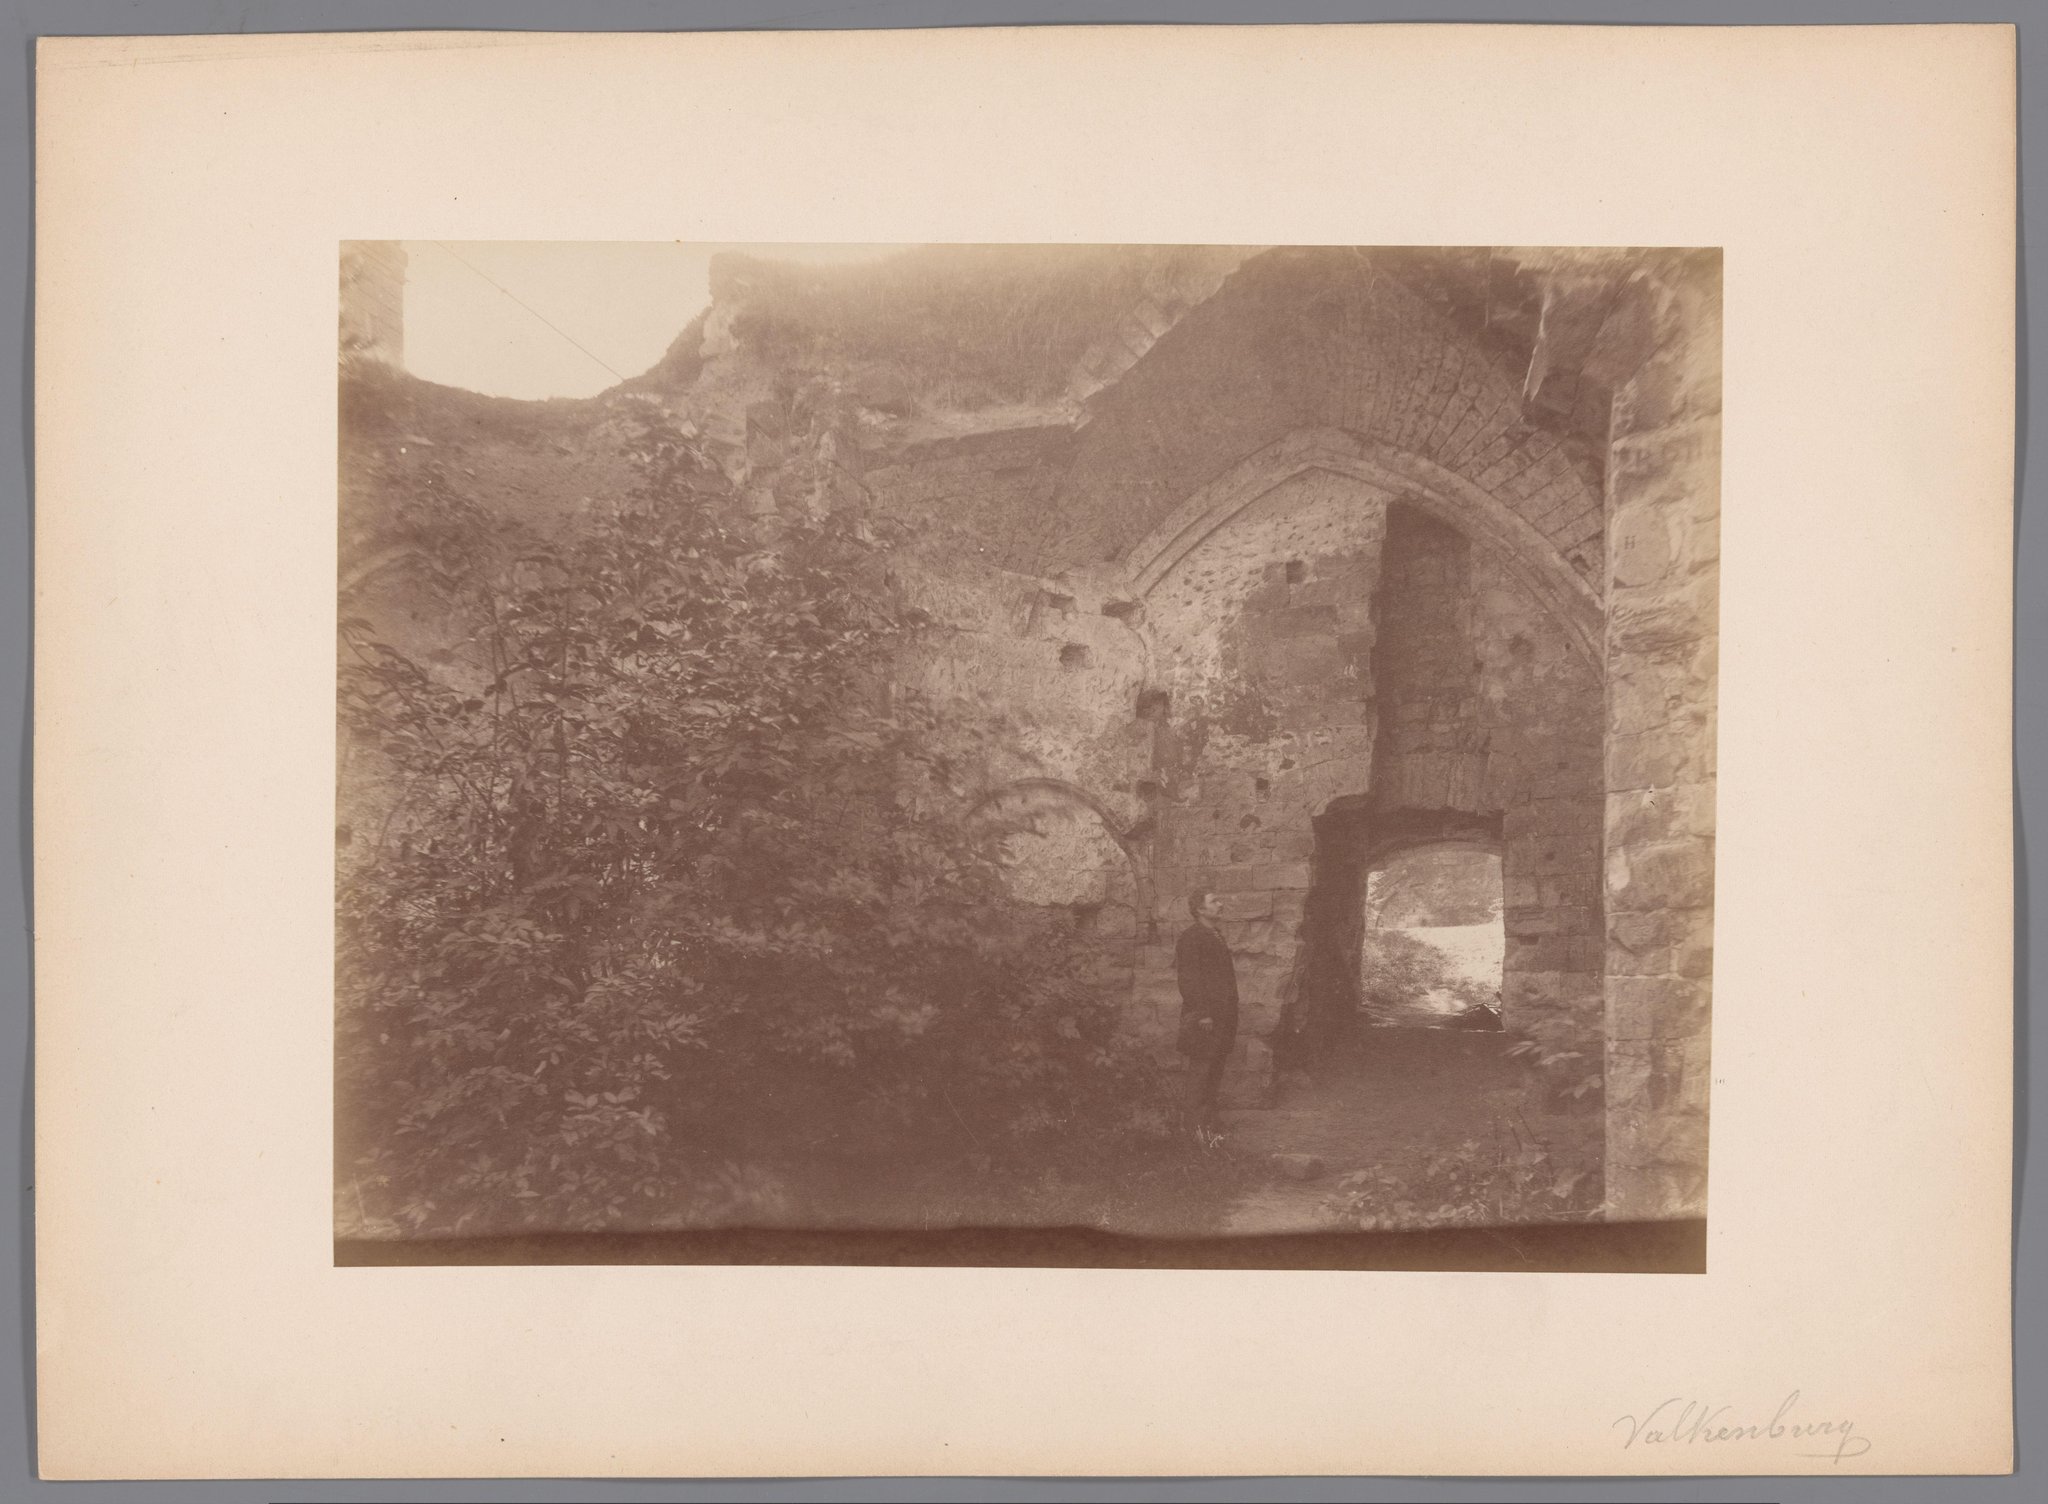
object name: photograph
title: Kapel van de kasteelruïne te Valkenburg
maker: anoniem (monumentenzorg)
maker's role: fotograaf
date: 1890-1920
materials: cardboard, photographic support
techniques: albumen print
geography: valkenburg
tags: ruin of a dwelling, house, castle, etc.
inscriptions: annotation: ‘Valkenburg’, annotation: ‘Ruïne te Valkenburg/ Aanzicht in de kapel’